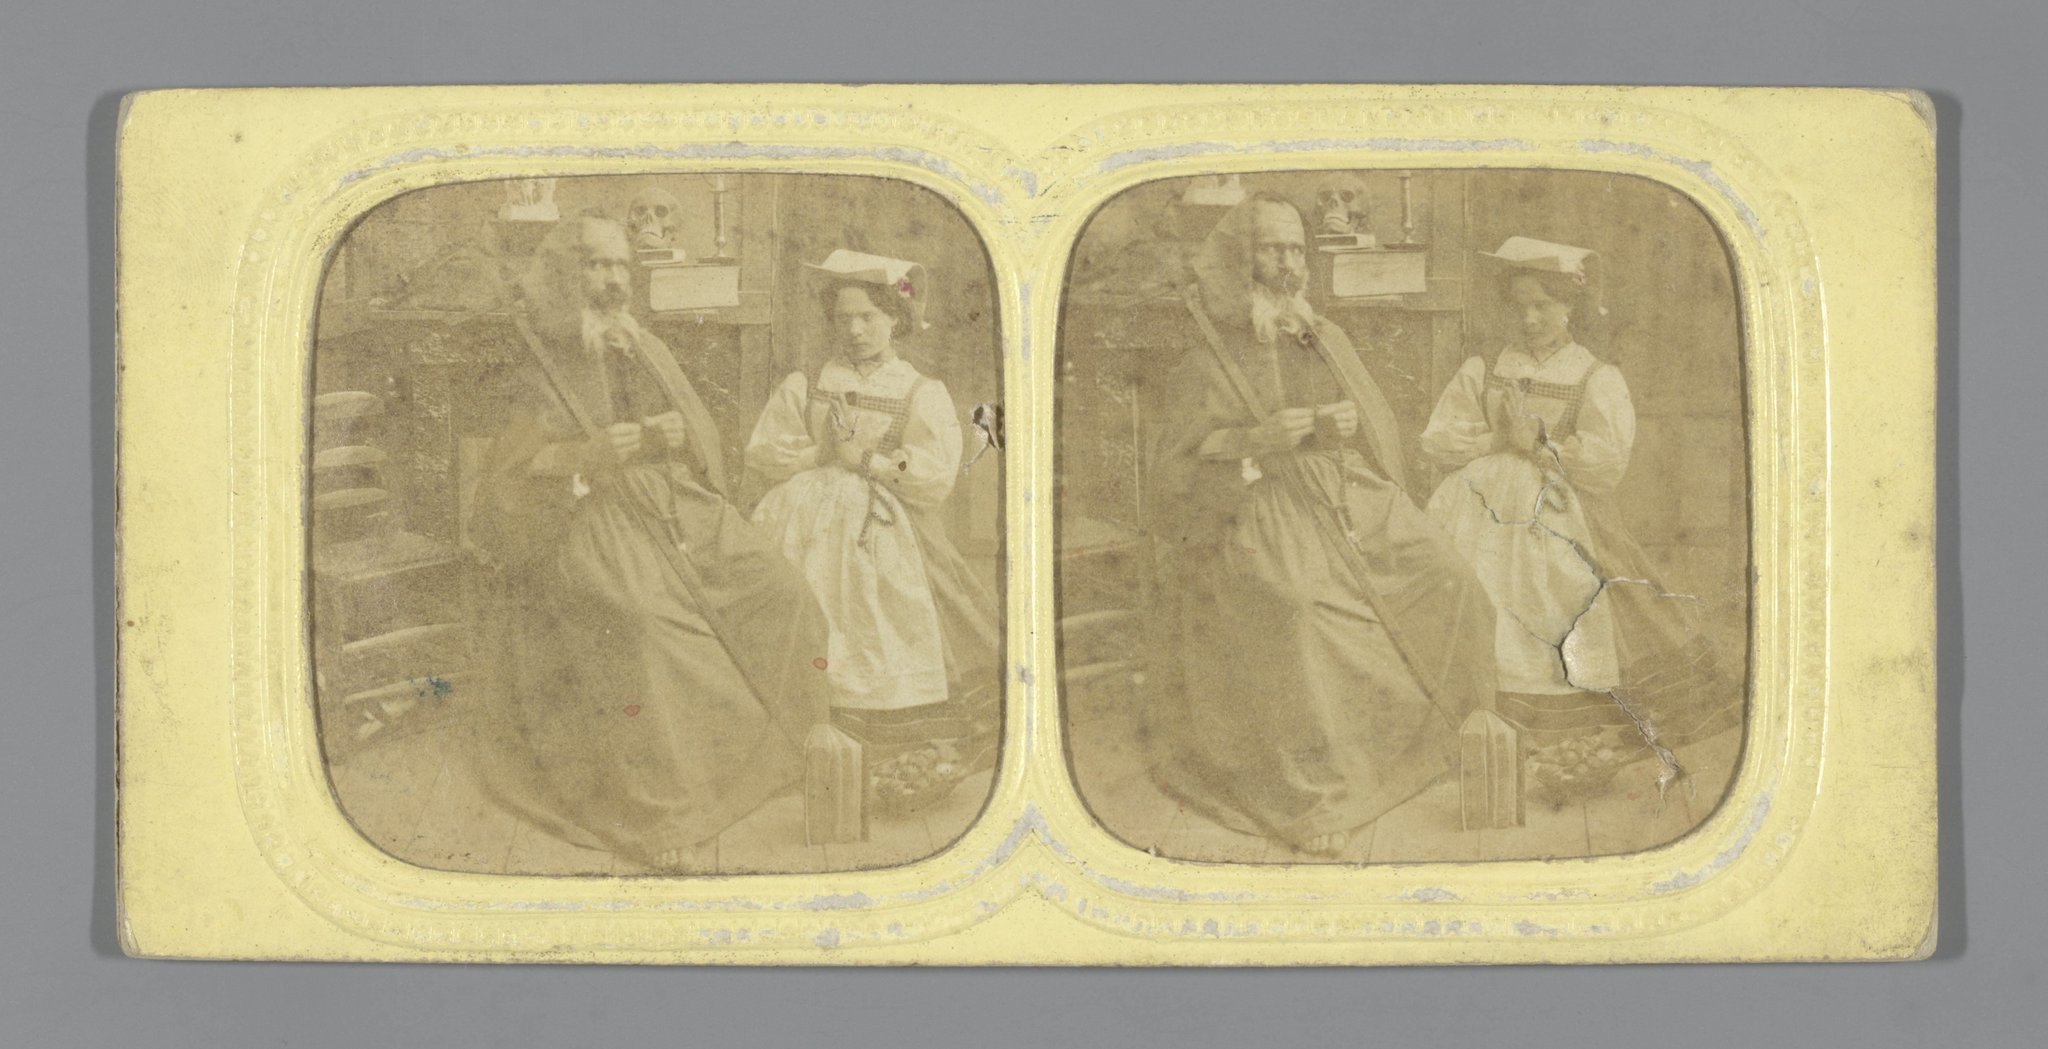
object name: tissue stereograph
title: Man en vrouw bidden de rozenkrans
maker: Anonymous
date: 1855-1875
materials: cardboard, paper, photographic support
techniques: albumen print, hand coloring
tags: saying the rosary